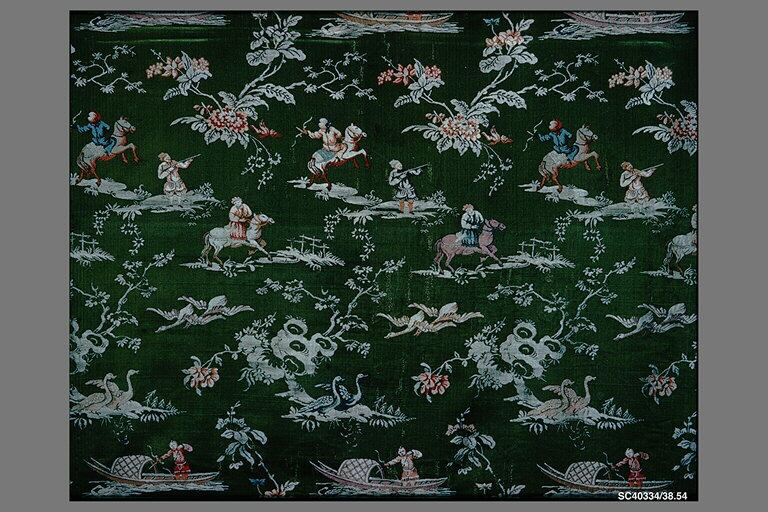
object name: piece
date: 1734-1766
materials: silk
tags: birds,men,horses,boats